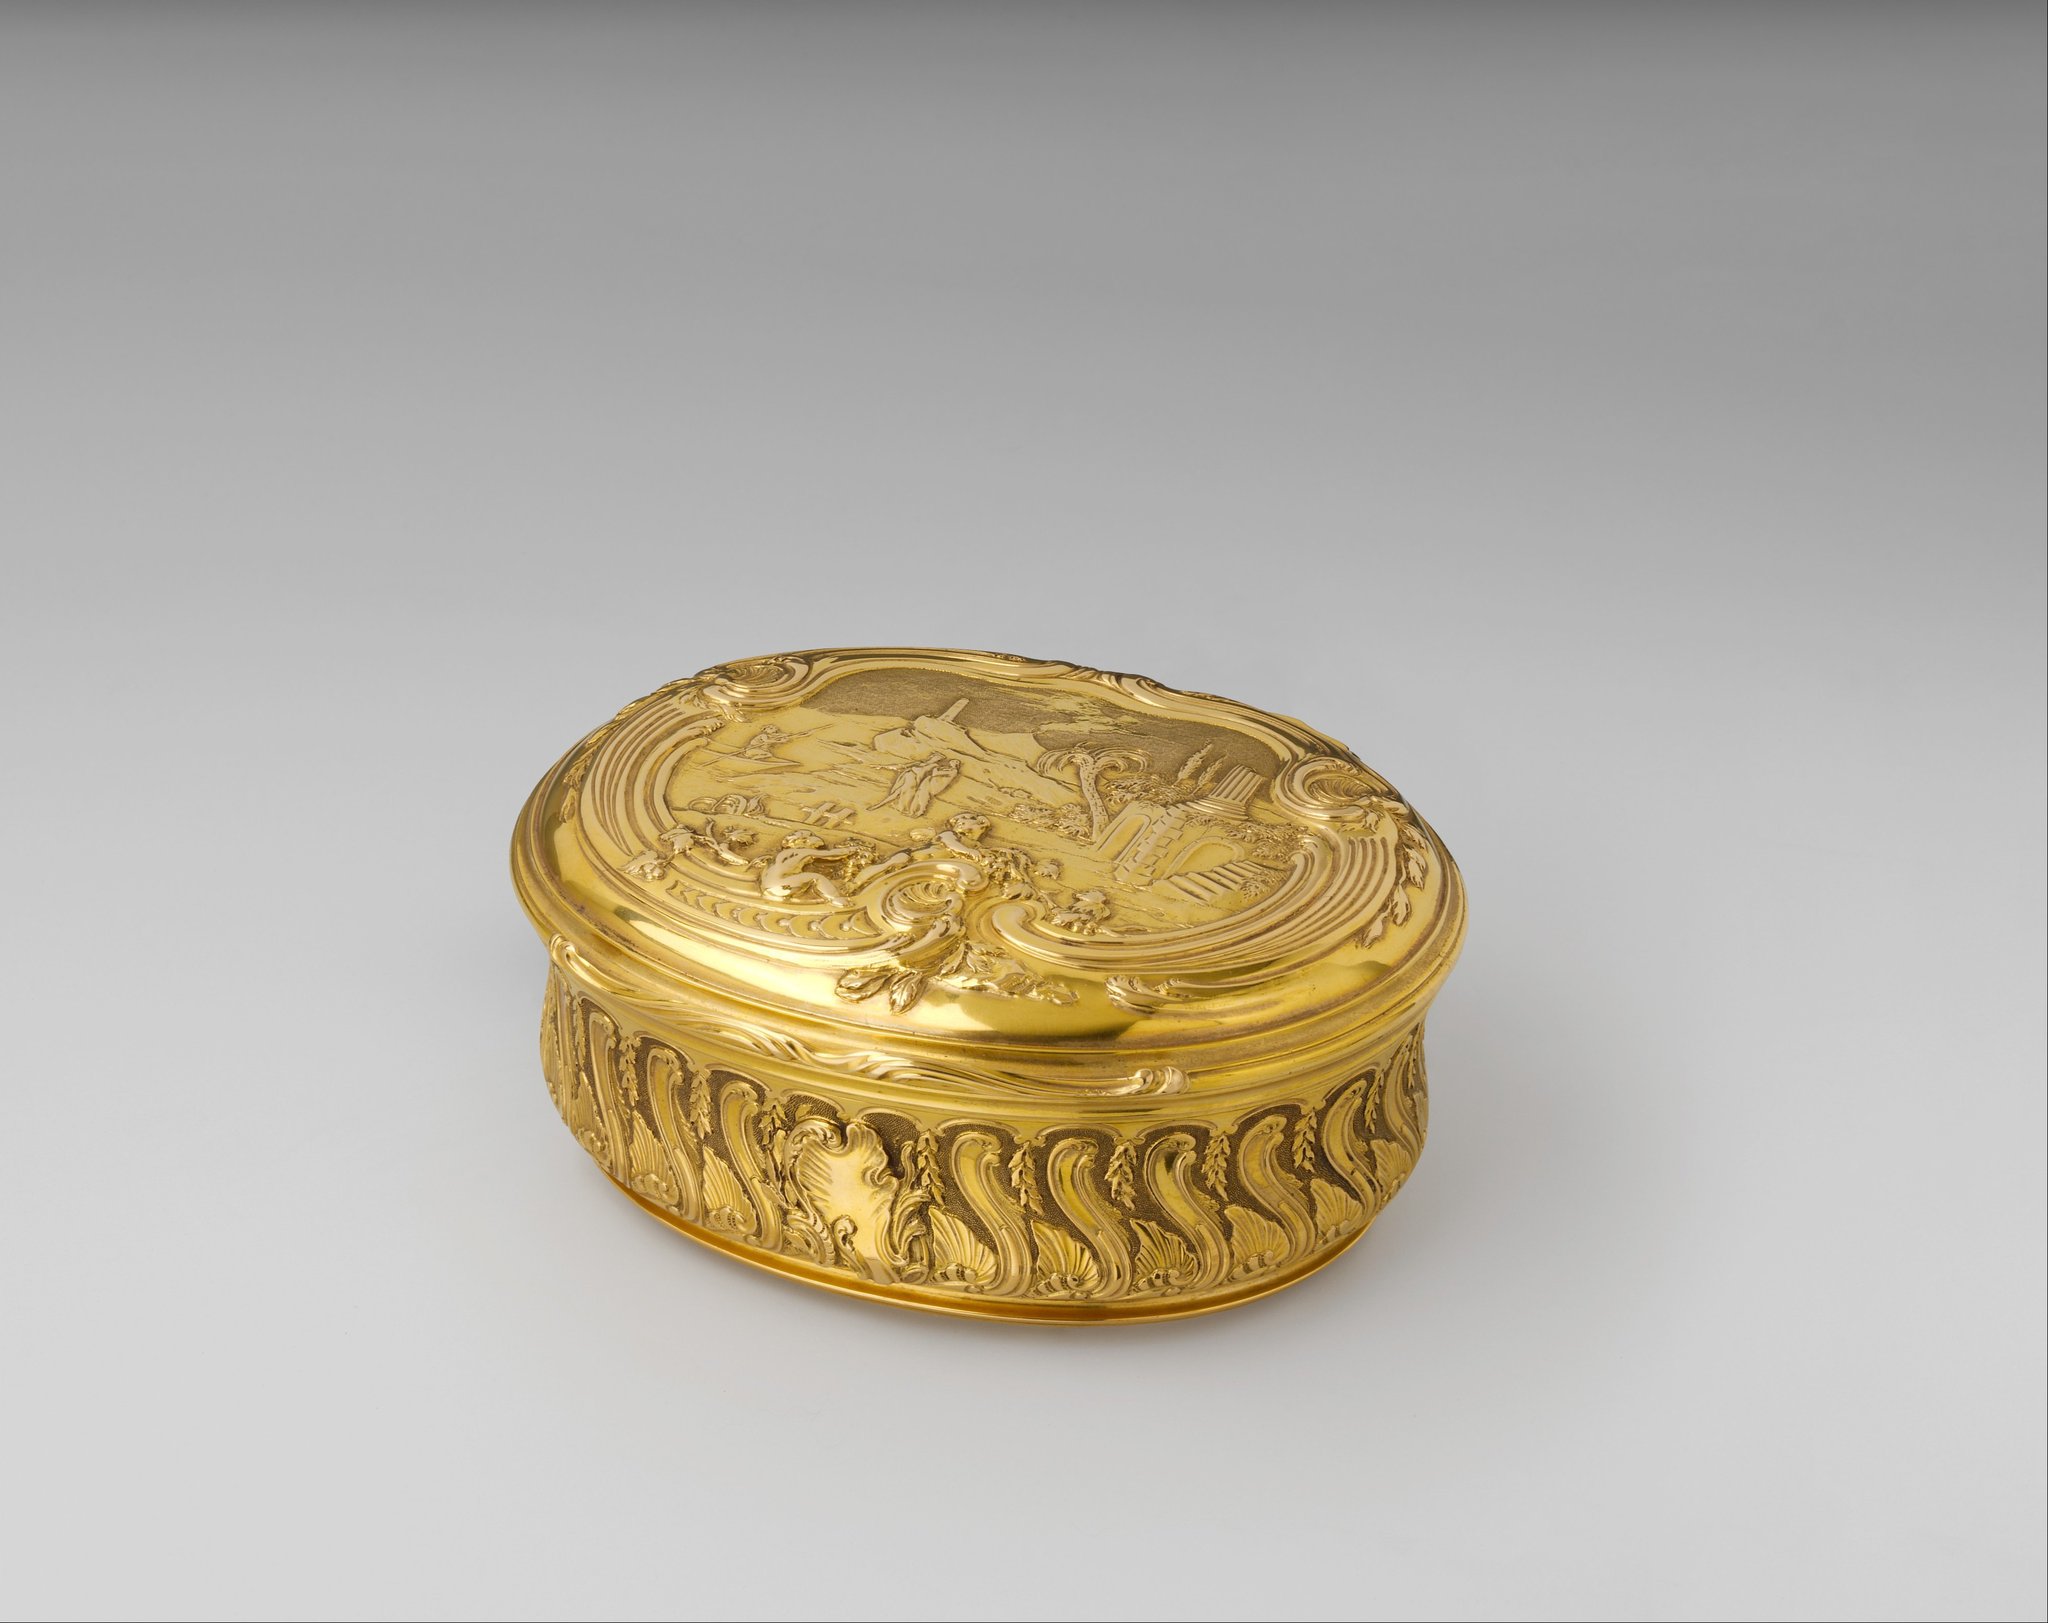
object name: snuffbox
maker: jean ducrollay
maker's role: maker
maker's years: 1709-1760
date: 1736-1737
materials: gold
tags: portraits,women,landscapes